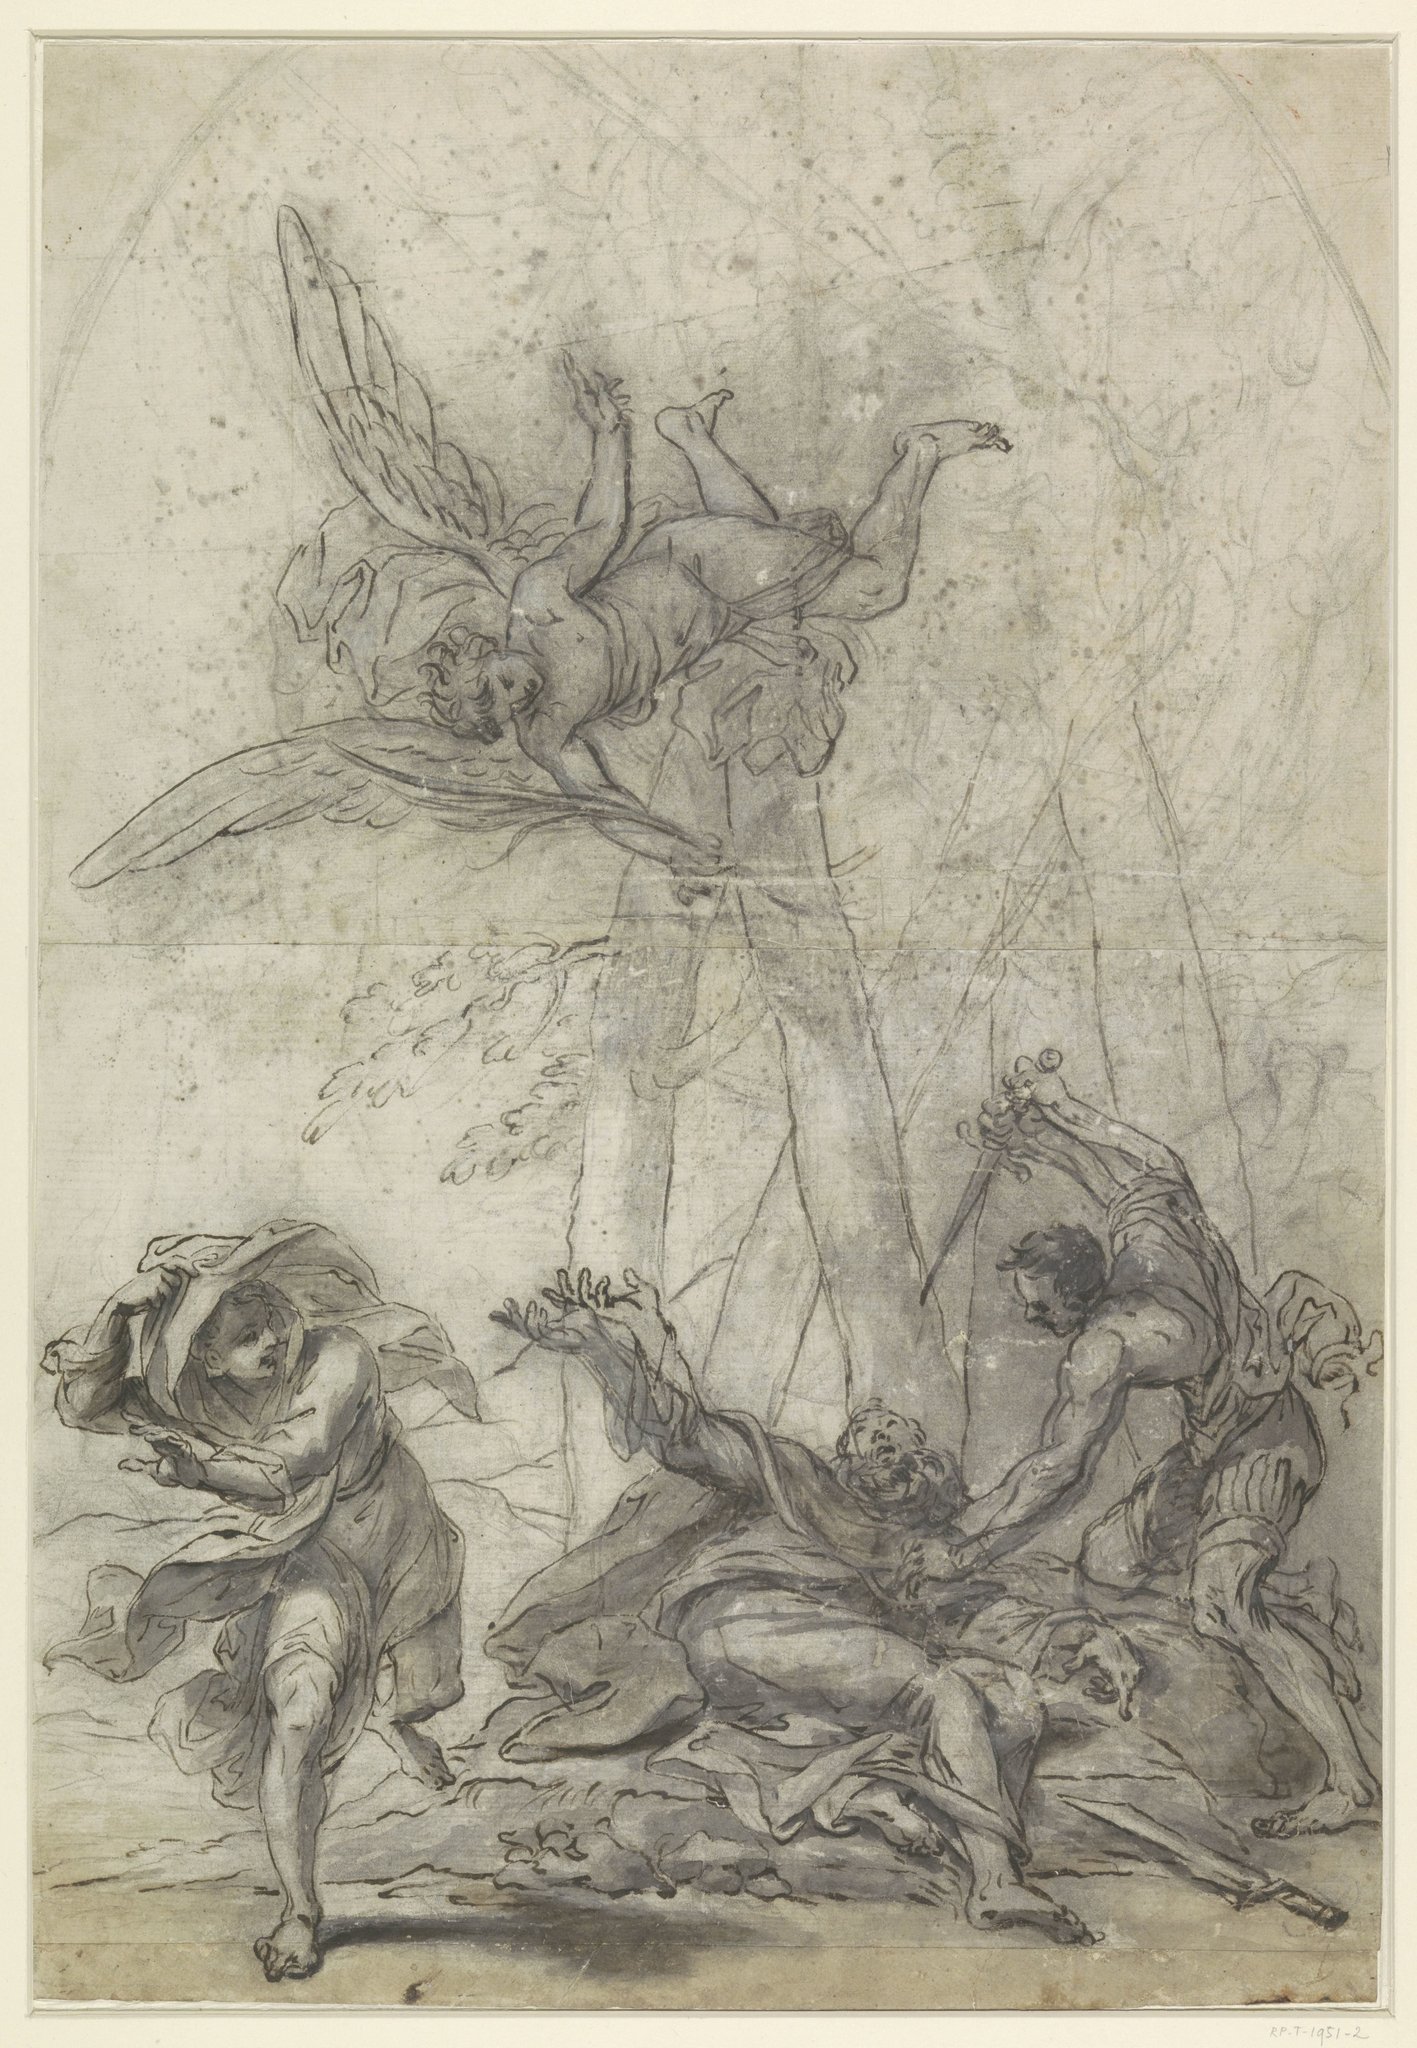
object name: drawing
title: Martelaarschap van de heilige Petrus Martyr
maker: marco marcola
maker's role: draughtsman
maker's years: 1740-1793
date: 1750-1793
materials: chalk, ink, paper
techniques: brush, pen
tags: st. peter martyr is murdered (in a forest) by two assassins with a sword; with his blood he writes on the ground 'credo in deum' (usually a fellow friar is also attacked or murdered)